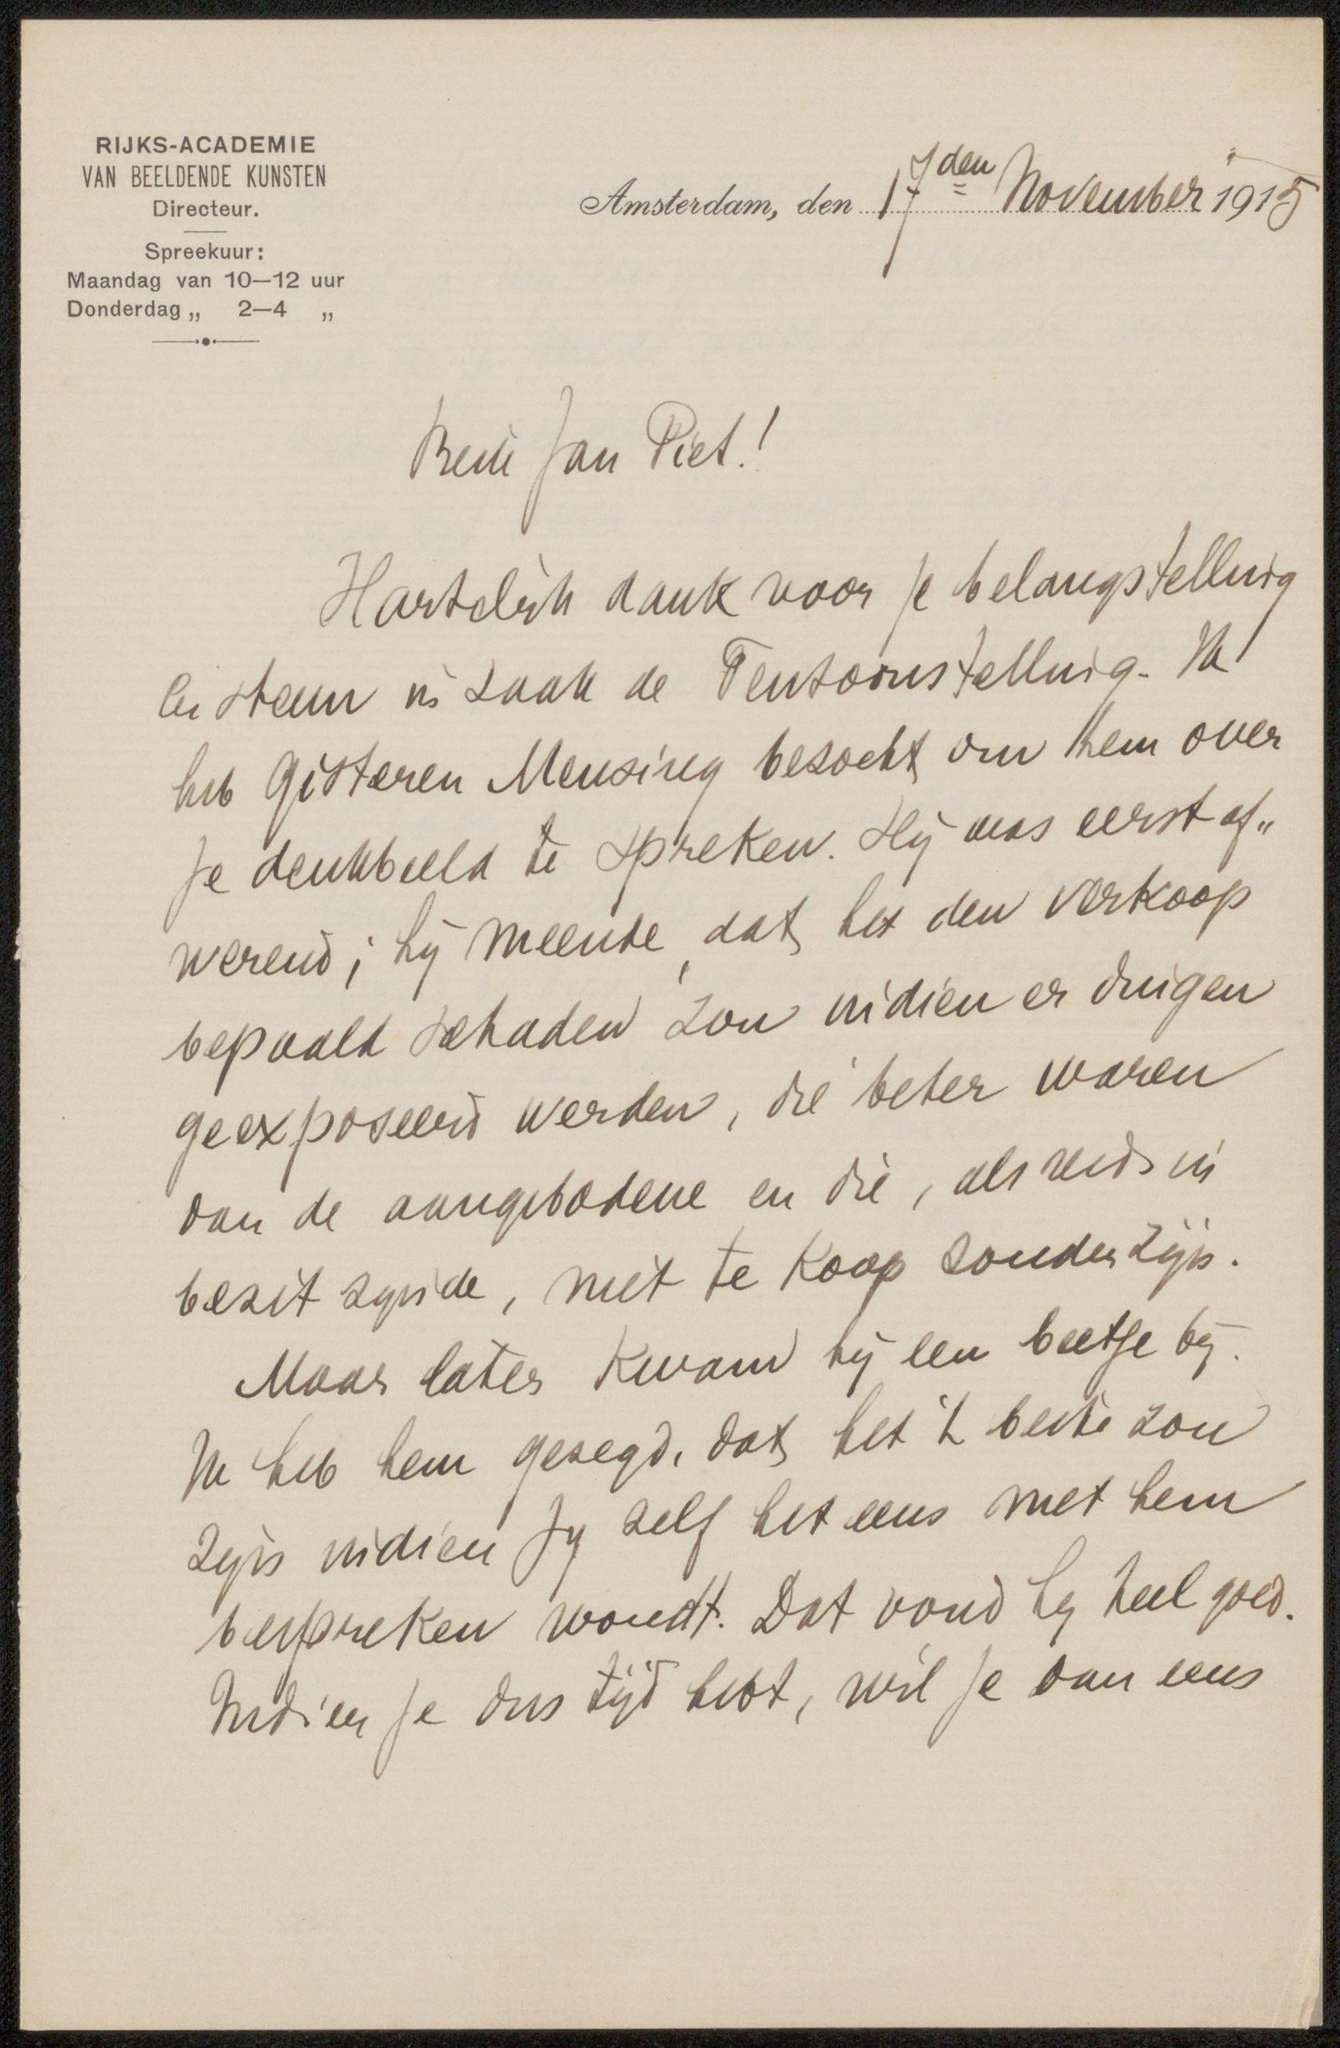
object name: letter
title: Brief aan Jan Veth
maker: antoon derkinderen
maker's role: draughtsman, painter, print maker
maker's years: 1859-1925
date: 1915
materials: ink, paper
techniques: pen, printing, writing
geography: amsterdam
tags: dordrecht, painter, print maker, draughtsman, designer, jan veth, antonius wilhelmus mari mensing, art trade, art shop, exhibition ~ art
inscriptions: collector's mark: ‘RPK’